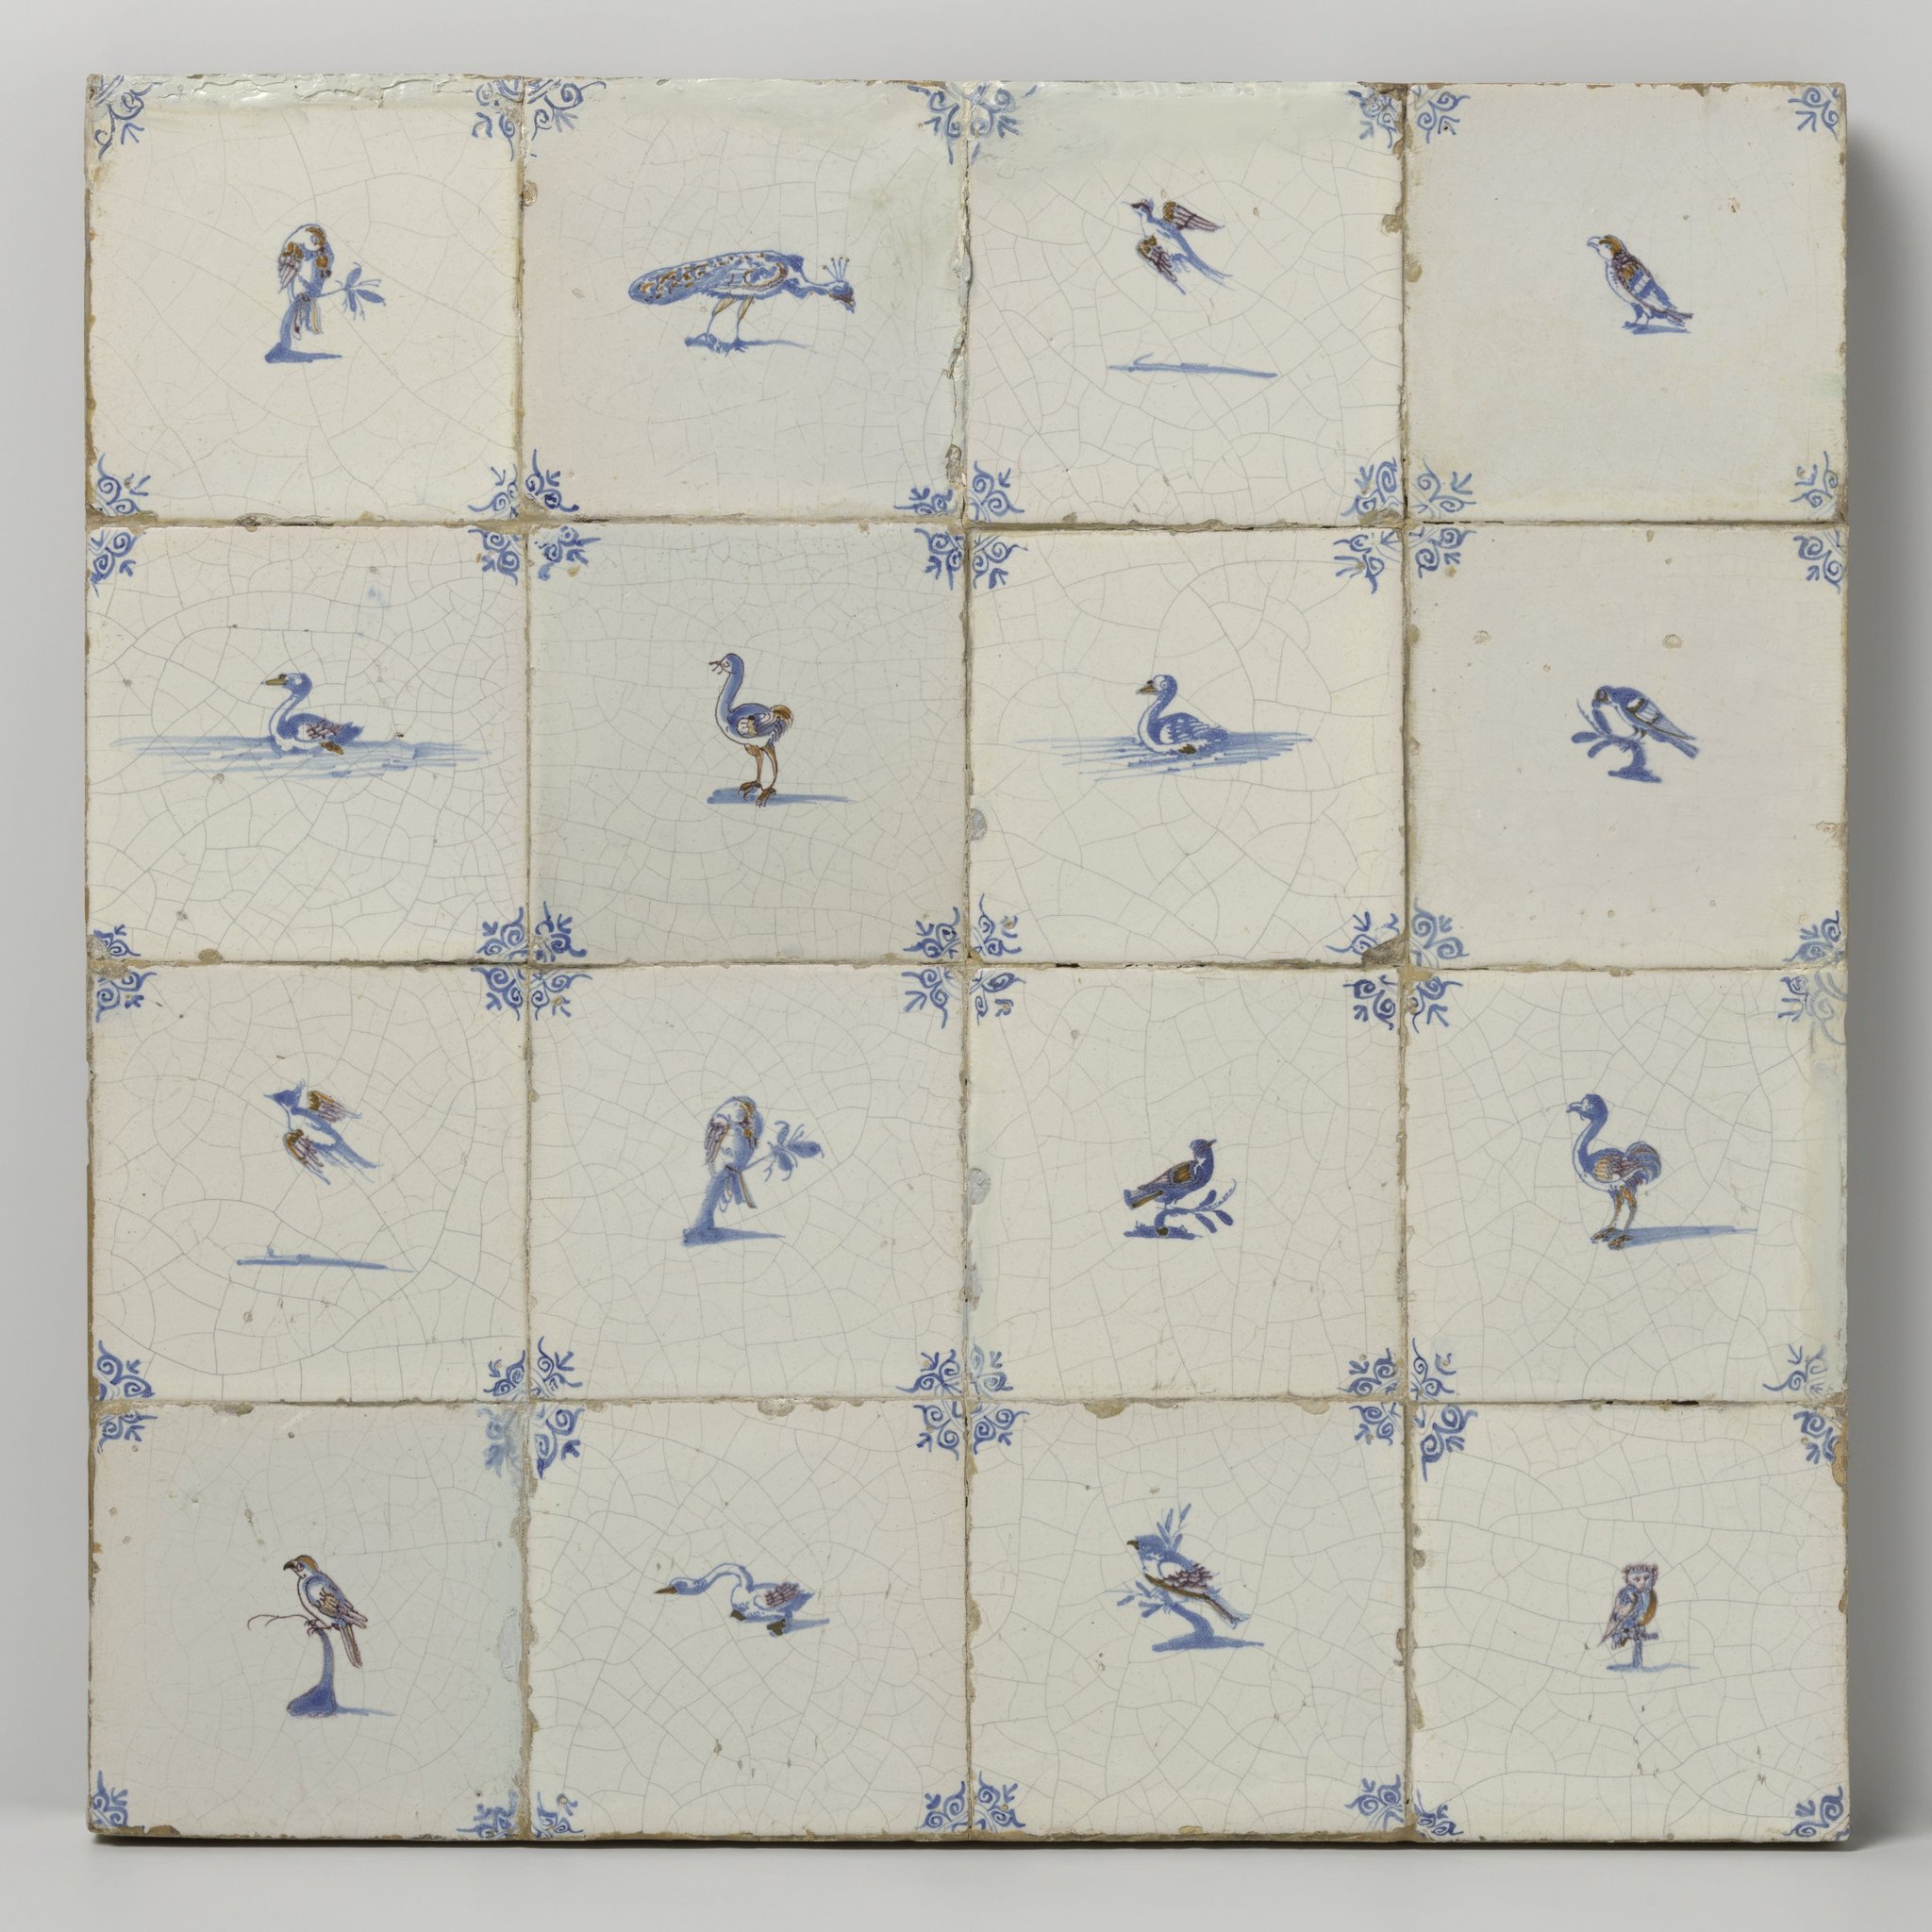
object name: vogeltegel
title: Veld van zestien tegels met vogels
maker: Anonymous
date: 1640-1660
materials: earthenware, glaze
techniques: maiolica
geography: netherlands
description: Veld van zestien tegels (4 x 4) elk met een veelkleurige (blauw, oranje en paars) geschilderde vogel op een tak en in de hoeken, een ossenkop.